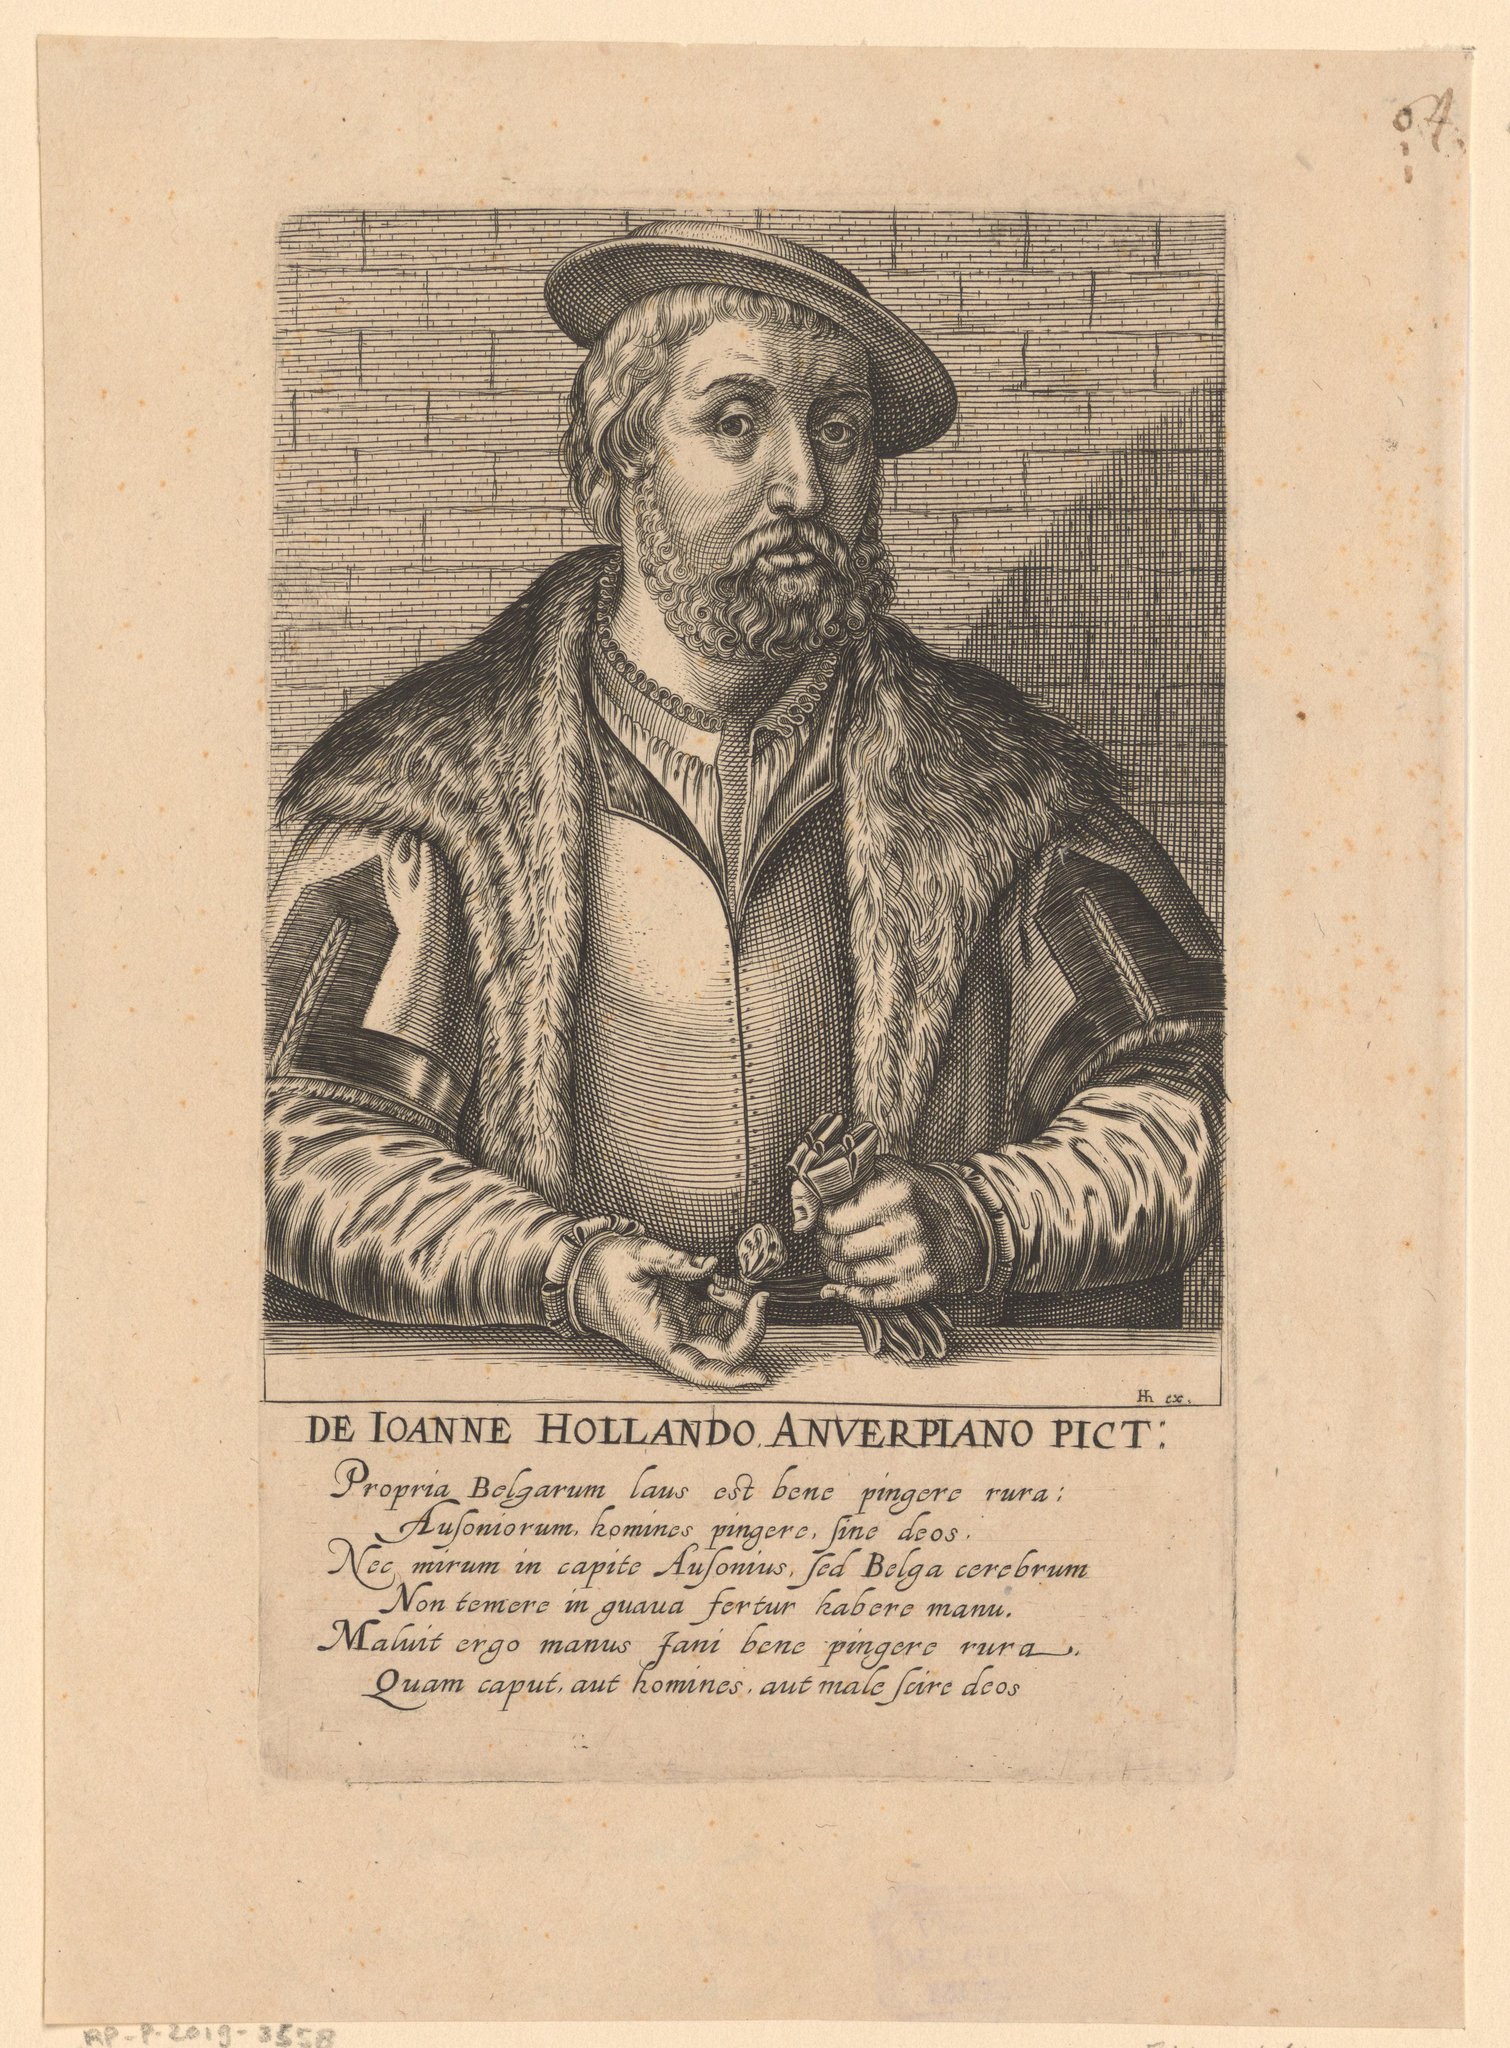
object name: print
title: Portret van Jan van Amstel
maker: hendrick hondius (i)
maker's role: draughtsman, print maker, publisher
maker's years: 1573-1650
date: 1610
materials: paper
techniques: engraving, etching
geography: the hague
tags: amsterdam, antwerp, painter, draughtsman, historical persons, portrait, self-portrait of painter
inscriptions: collector's mark: Lugt 11, inscription: ‘64.’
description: Simon Schijnvoet heeft in 1709 aan het album het Schijnvoet-nummer 16 toegekend. Prent uit: Hondius, Hendrick. Pictorum aliquot celebrium praecipuae Germaniae inferioris effigies. Den Haag: Hendrick Hondius, [ca. 1610]. Prenten opnieuw verschenen in de tweede editie (Amsterdam: Johannes Janssonius, 1618).